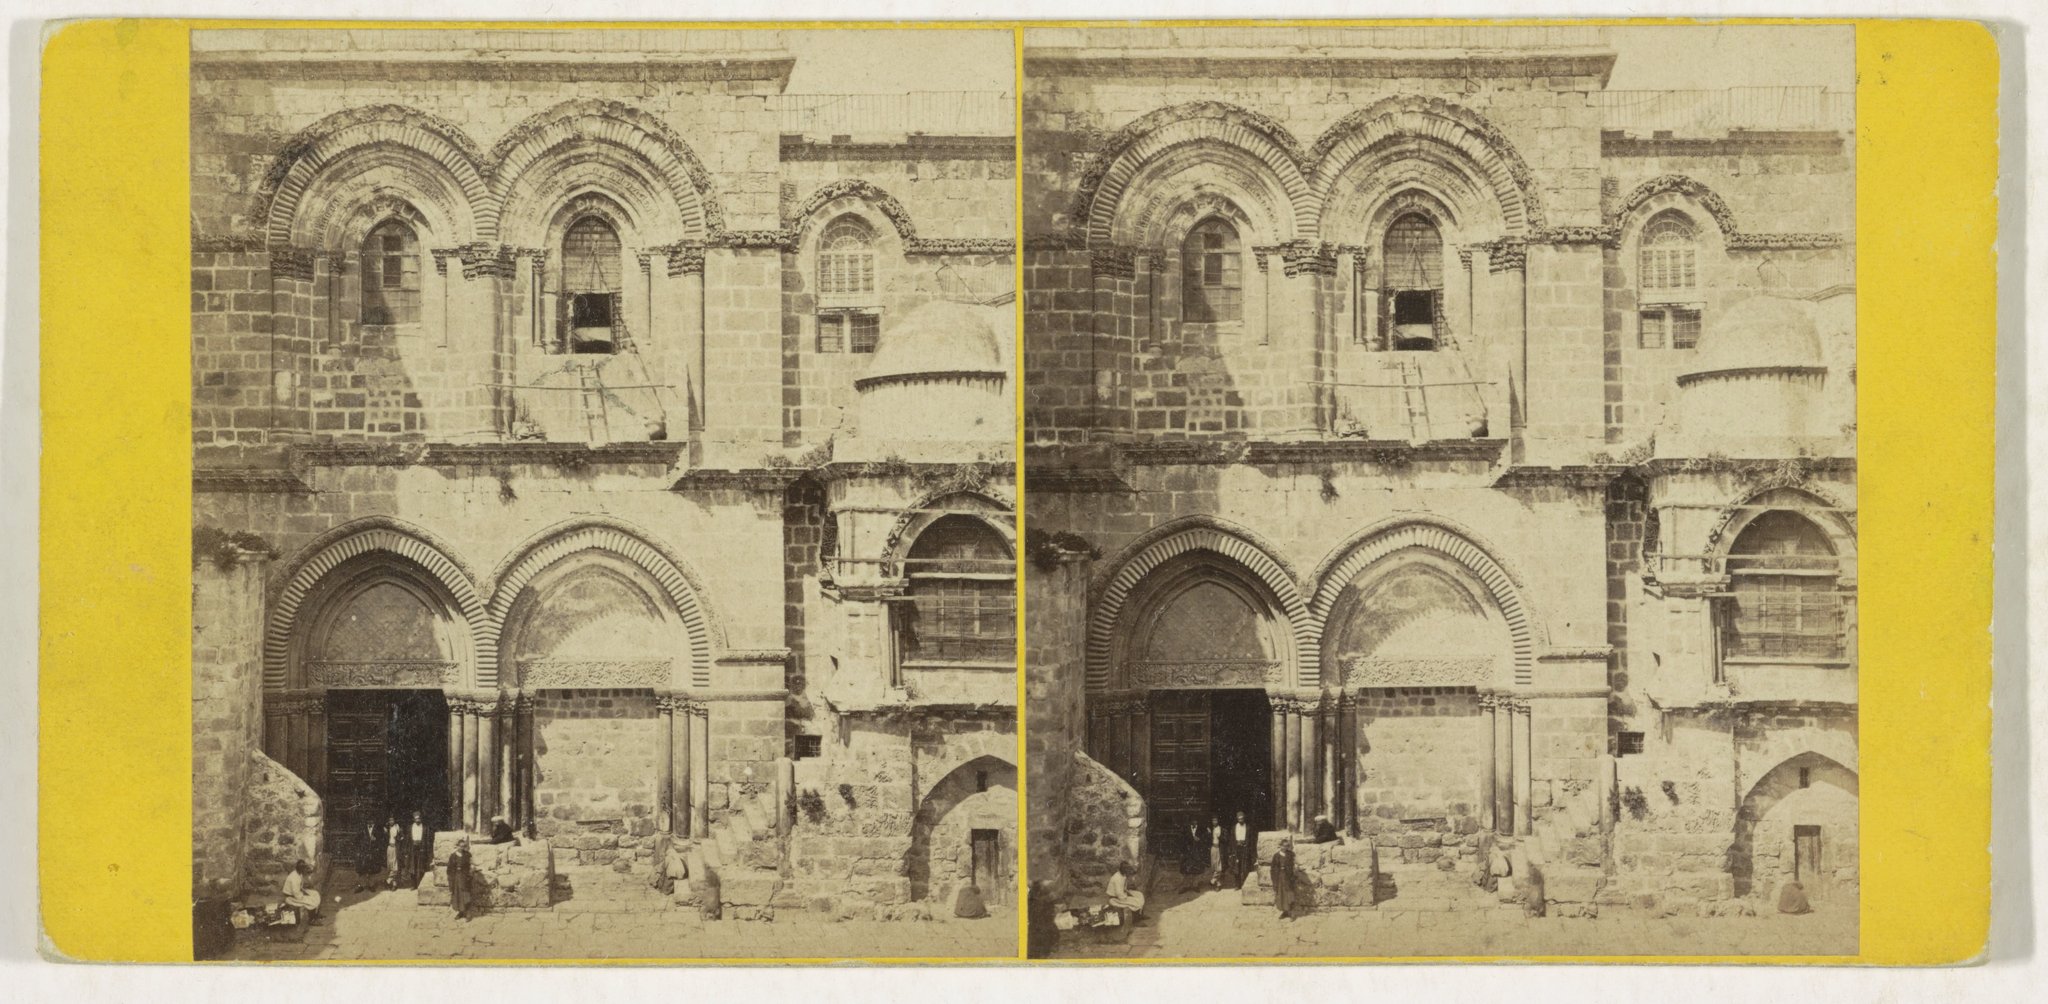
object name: stereograph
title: Good's Eastern Series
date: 1860-1880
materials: cardboard, paper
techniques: albumen print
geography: london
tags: gate, entrance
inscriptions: number: ‘No. 283.’